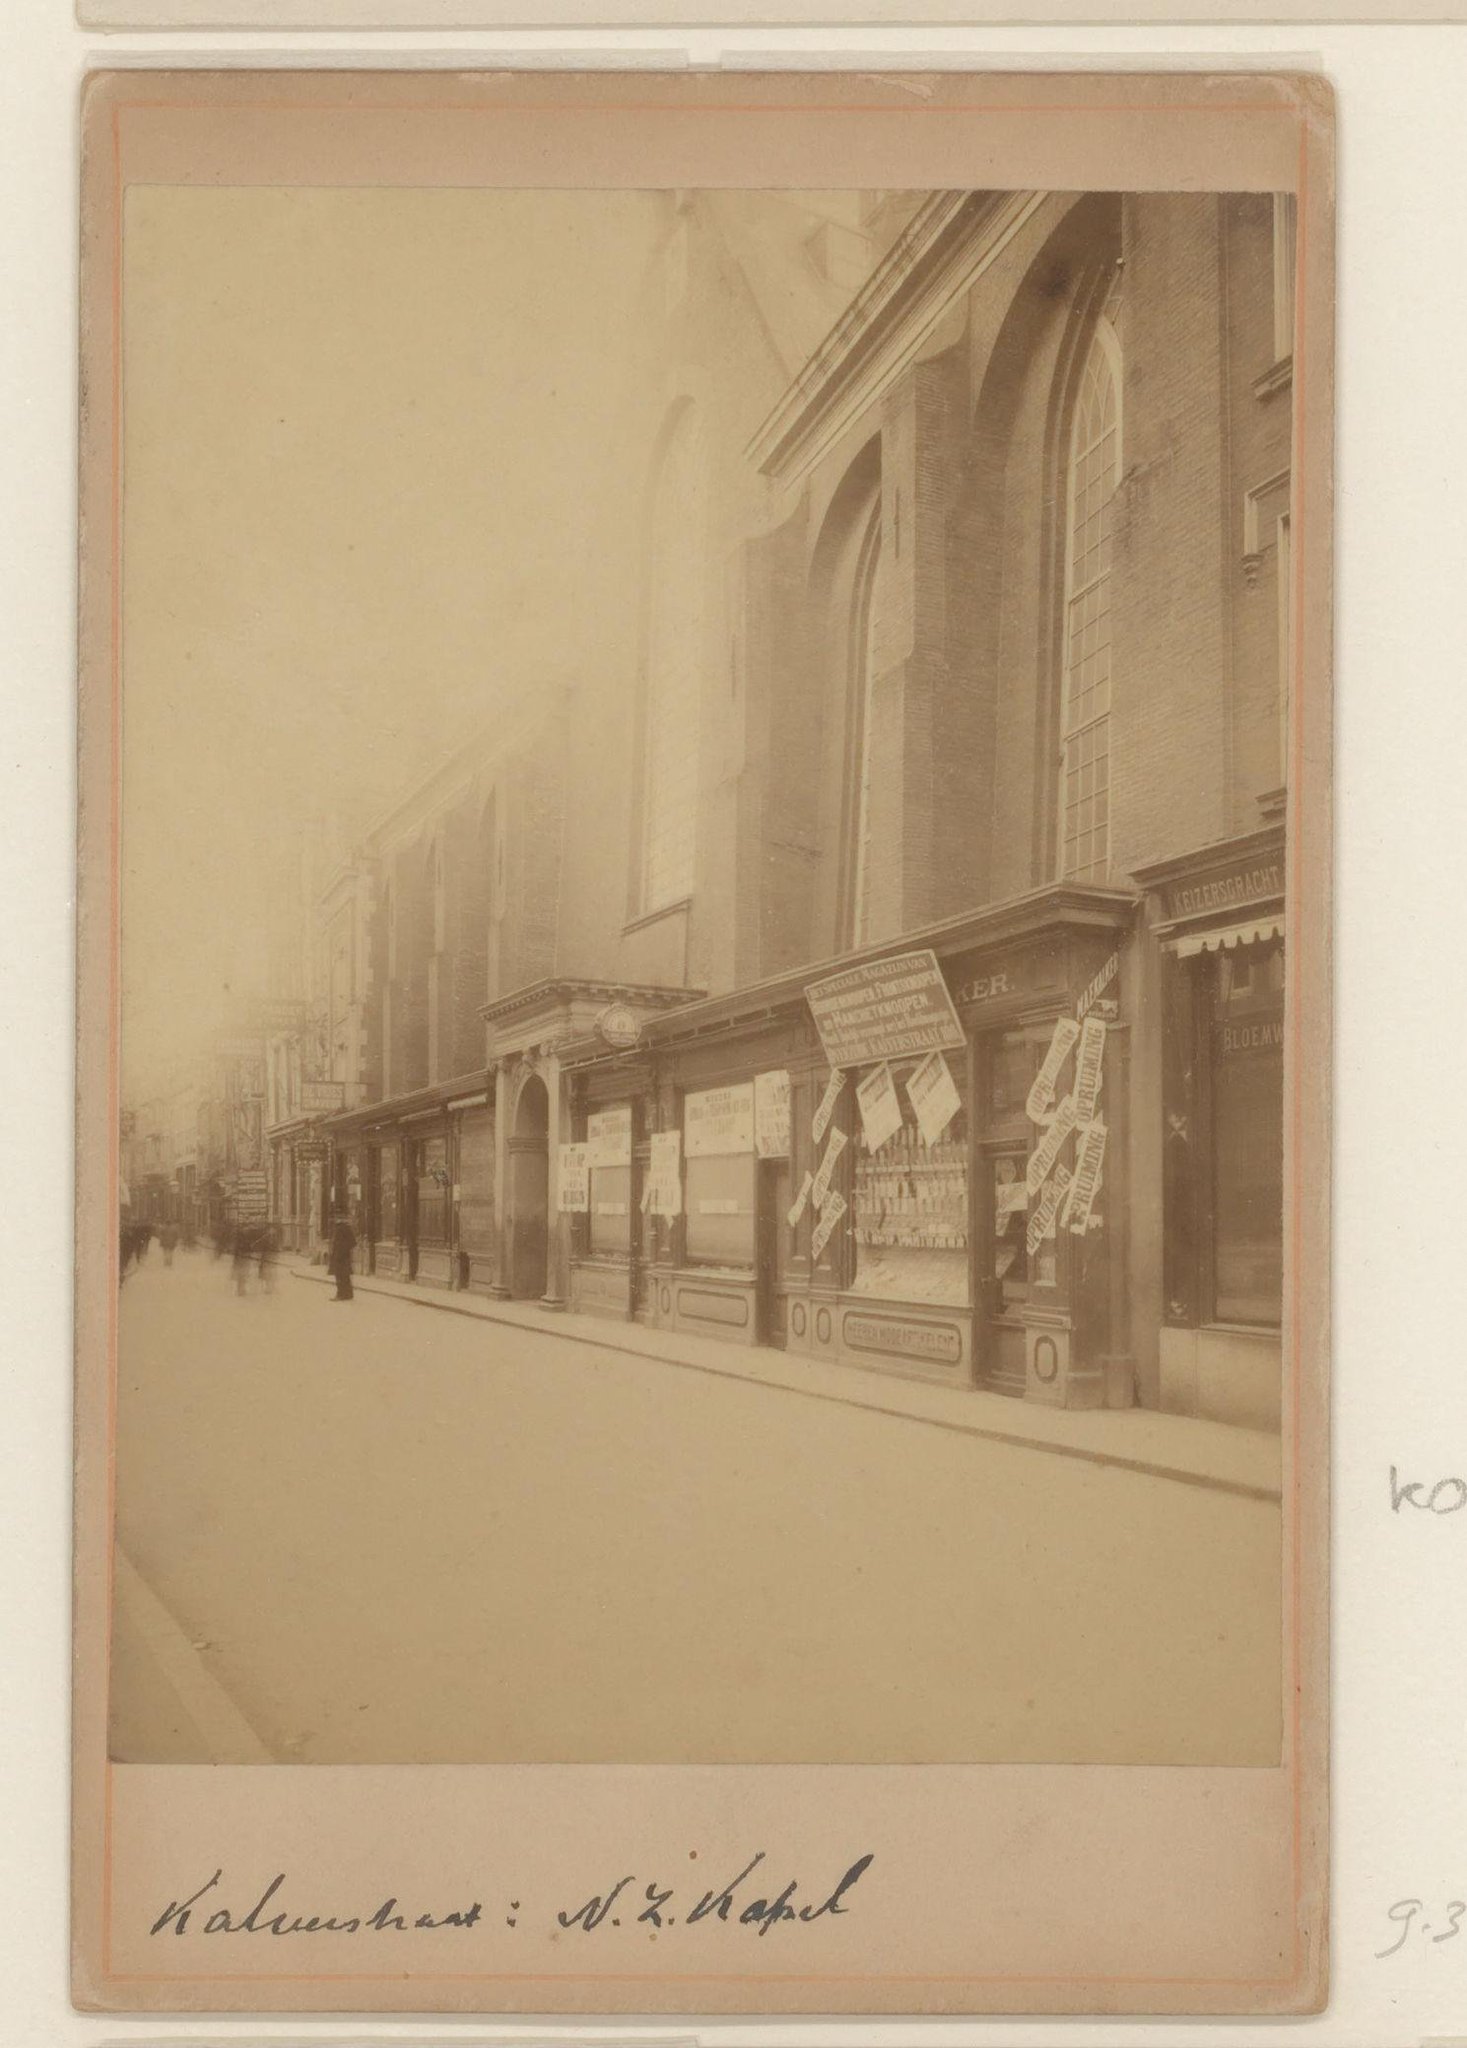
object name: cabinet photograph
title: Gezicht op de Nieuwezijds Kapel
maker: Anonymous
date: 1912-1915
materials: cardboard, paper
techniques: albumen print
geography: amsterdam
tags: city-view in general; 'veduta', church (exterior) - qq - small church, chapel, street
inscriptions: collector's mark: ‘9,3’ Lugt 1641b, inscription: ‘Kalverstraat: N.Z. Kapel’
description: Onderwerpsrubriek binnen de Atlas Amsterdam: Kadijksplein, Karthuizerkerkhof, Kattegat, Kattenburg, Kapelsteeg O.Z., Enge Kerksteeg, Kerkstraat, Kinkerstraat, Kolk O.Z., Koningsplein, Kromboomsloot [Krom Boomssloot], Kostverlorenkade, Kwakersdwarspad, Kalverstraat, Keizersgracht (v.d. Brouwersgracht – Amstel), Klerensloot (Gedempte), Klimopstraat, Kloveniersburgwal, Kraansluis.